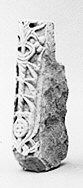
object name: fragment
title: Fragment of Molding with a Vegetal Motif Departing from a Round Element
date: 501-700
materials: limestone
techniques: carving, relief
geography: egypt